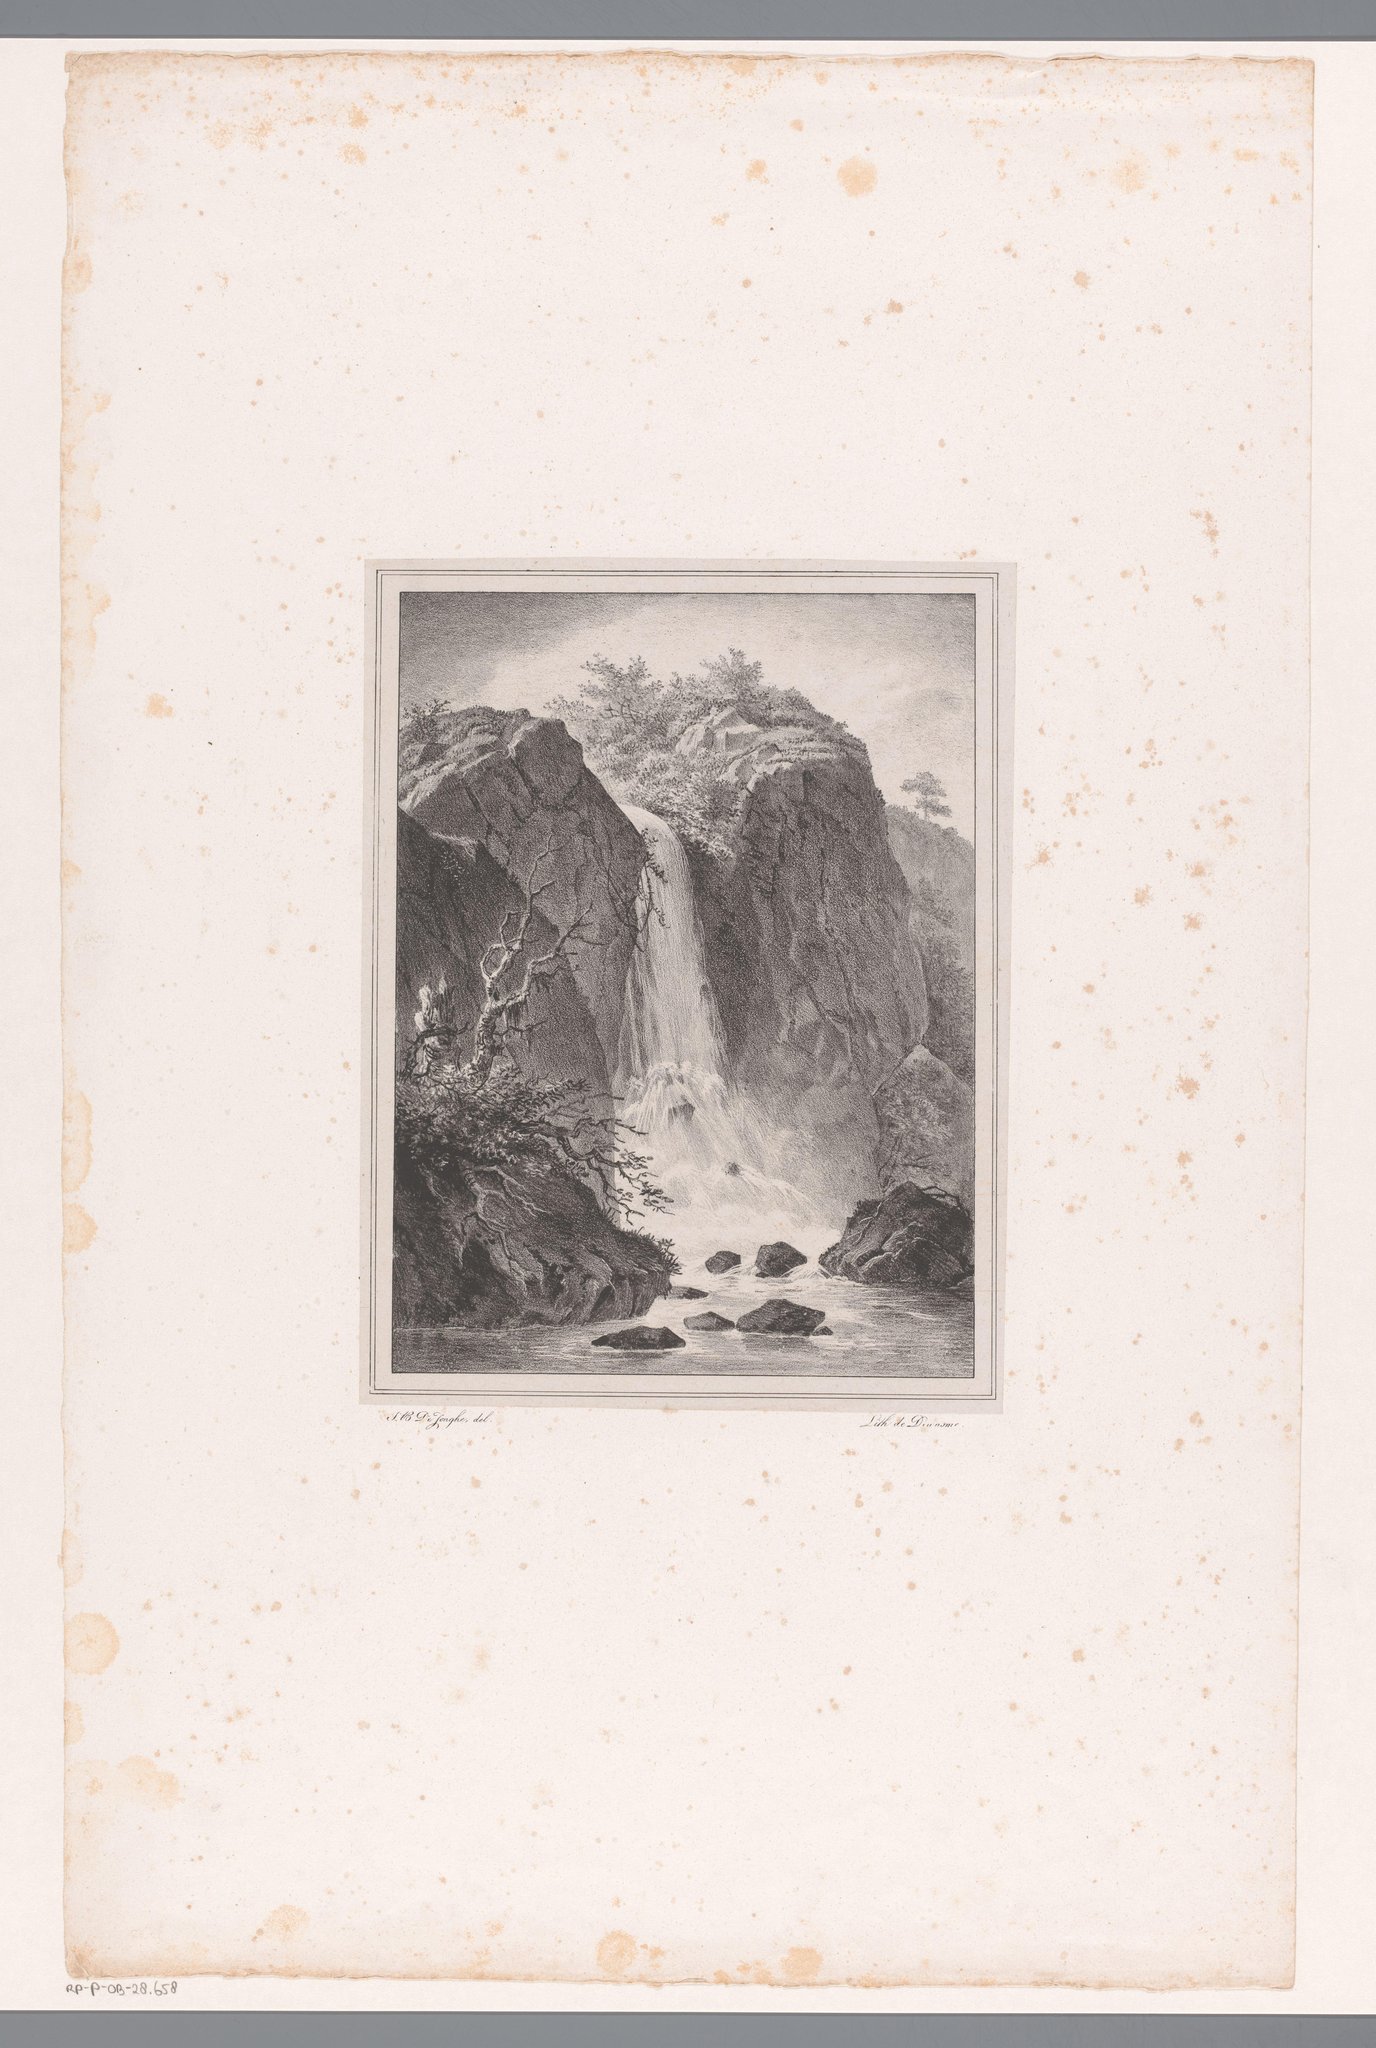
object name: print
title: Waterval tussen rotsen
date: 1800-1844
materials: paper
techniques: lithograph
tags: waterfall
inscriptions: collector's mark: Lugt 2228